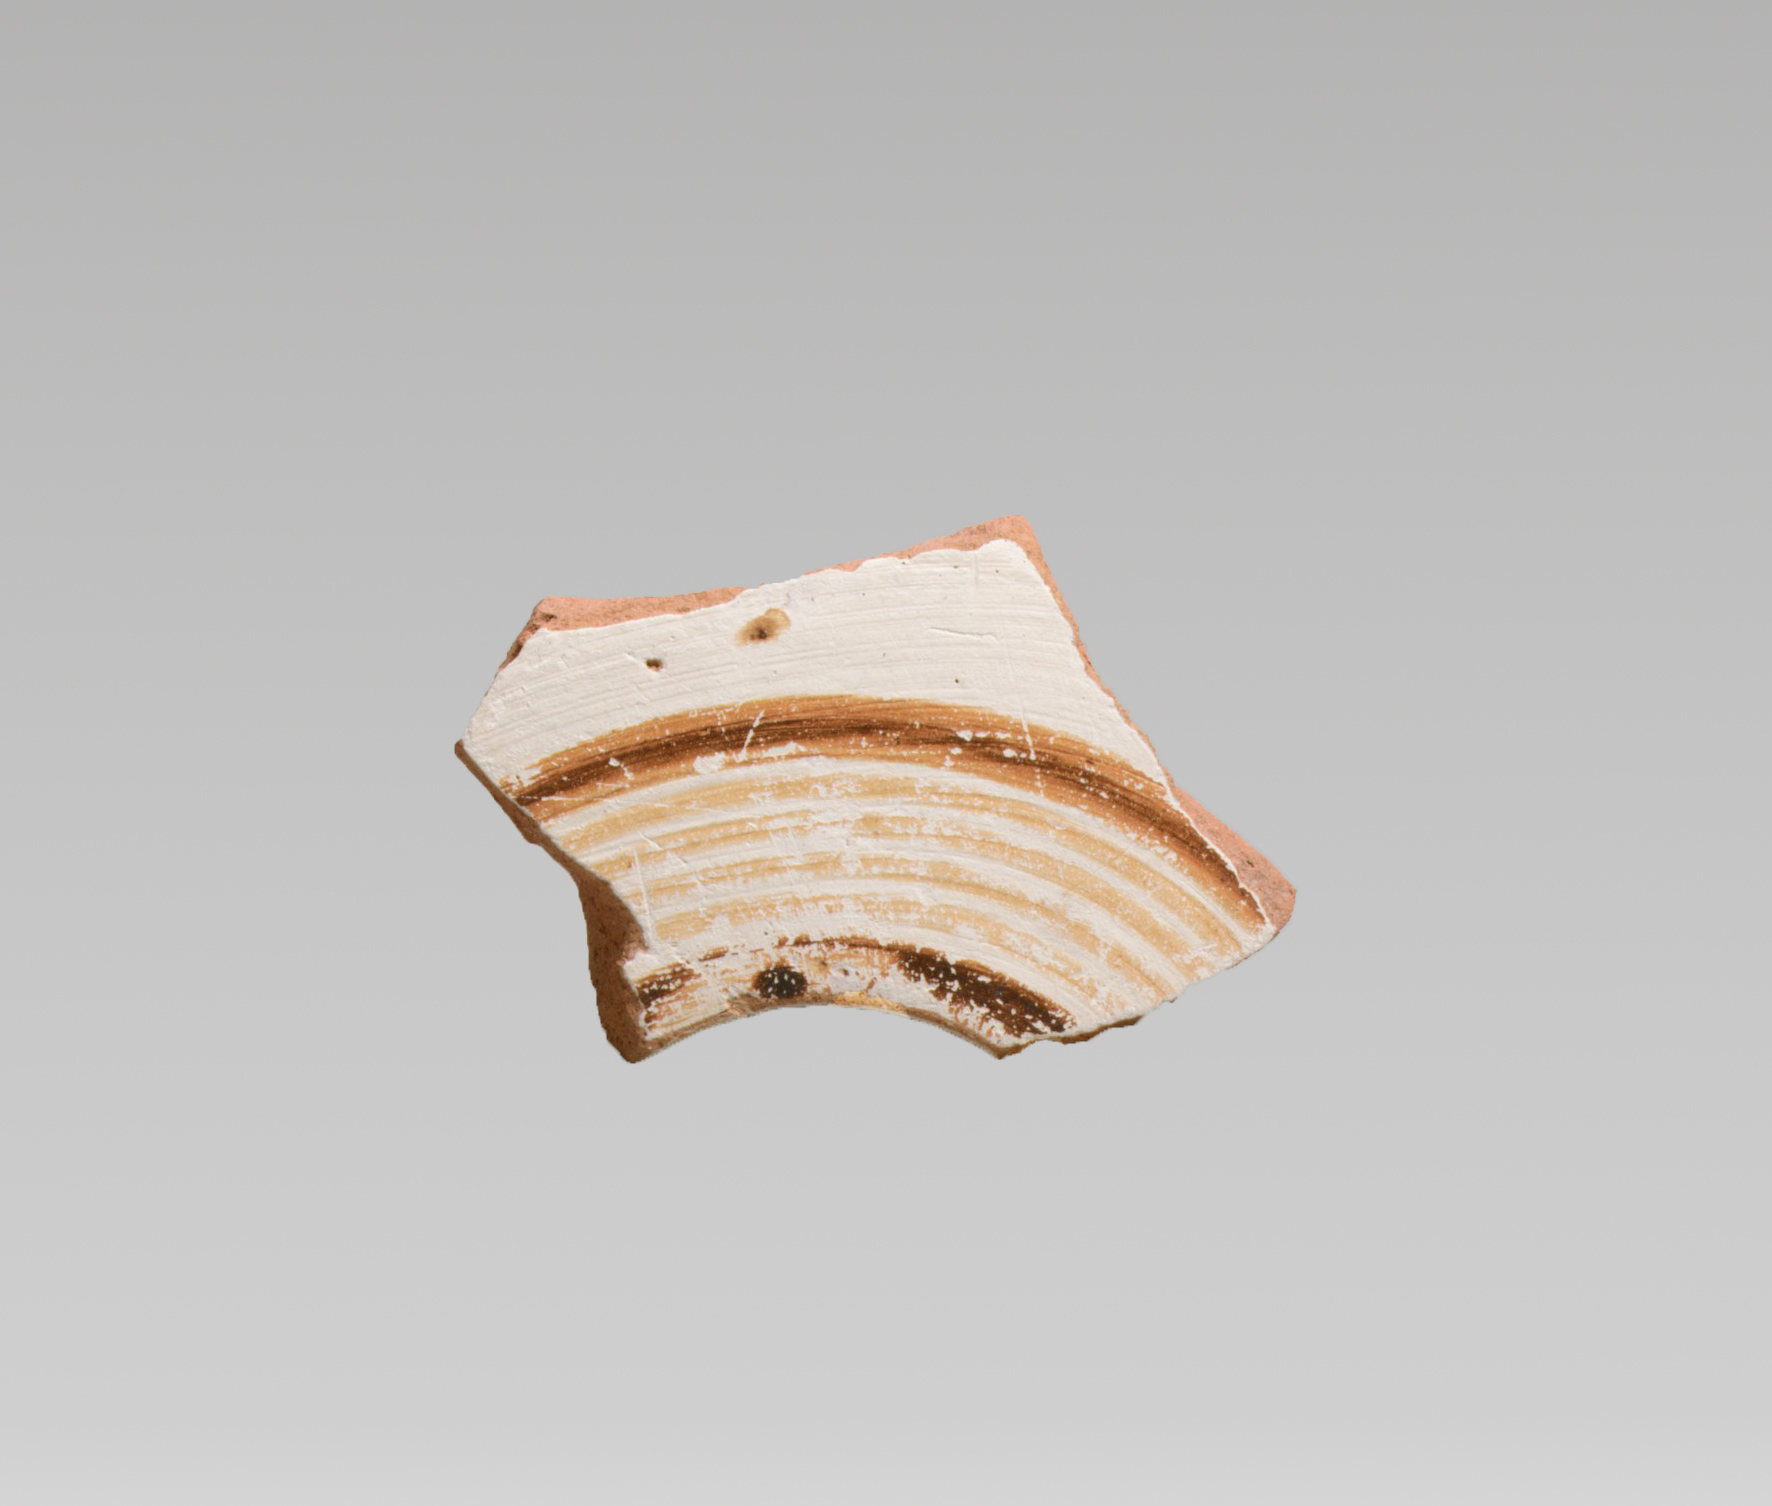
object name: vase fragment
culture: east greek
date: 700-601 BCE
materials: terracotta